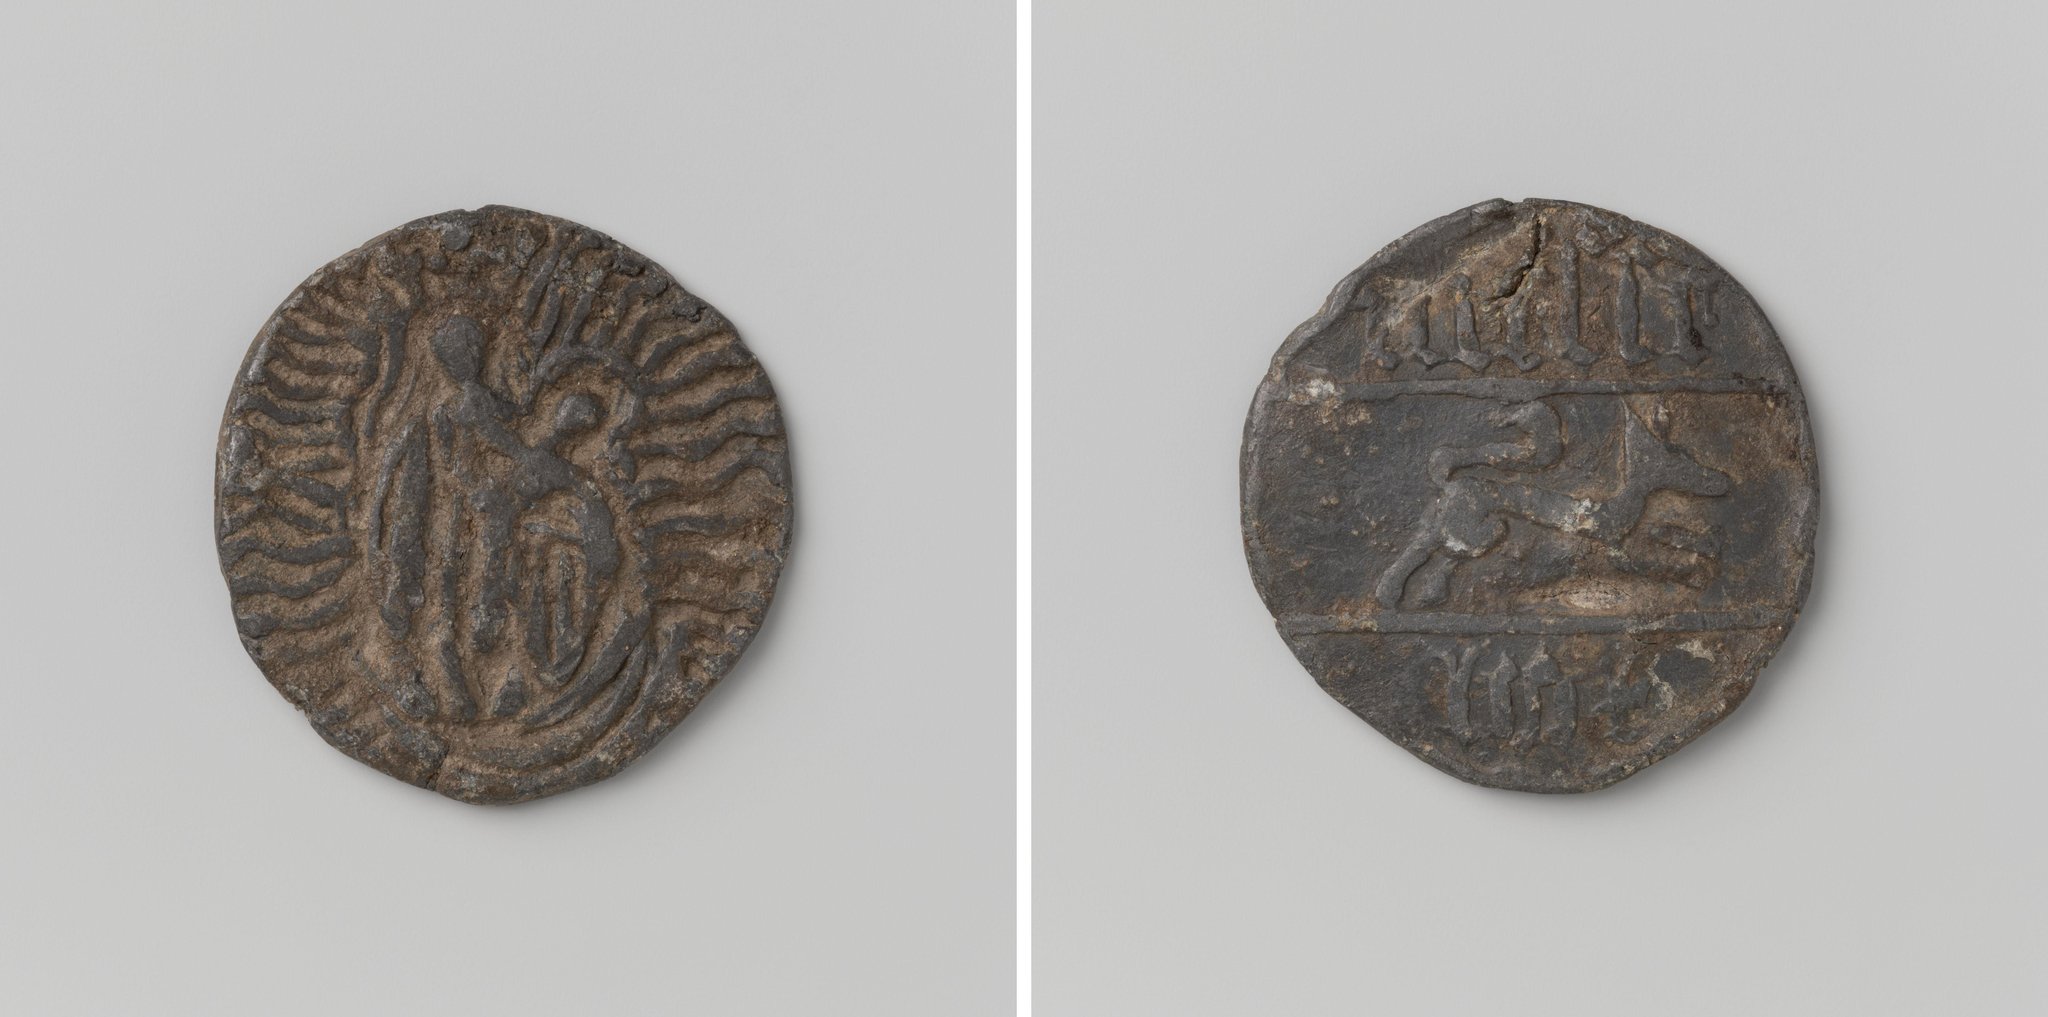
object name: devotional medal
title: Religieuze penning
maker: Anonymous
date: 1500-1700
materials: lead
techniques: casting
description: Loden penning. Voorzijde: Maria met lichaam van overleden Christus binnen stralenkrans. Keerzijde: naar rechts gewend rennend dier; onder en boven opschriften in Gothisch schrift